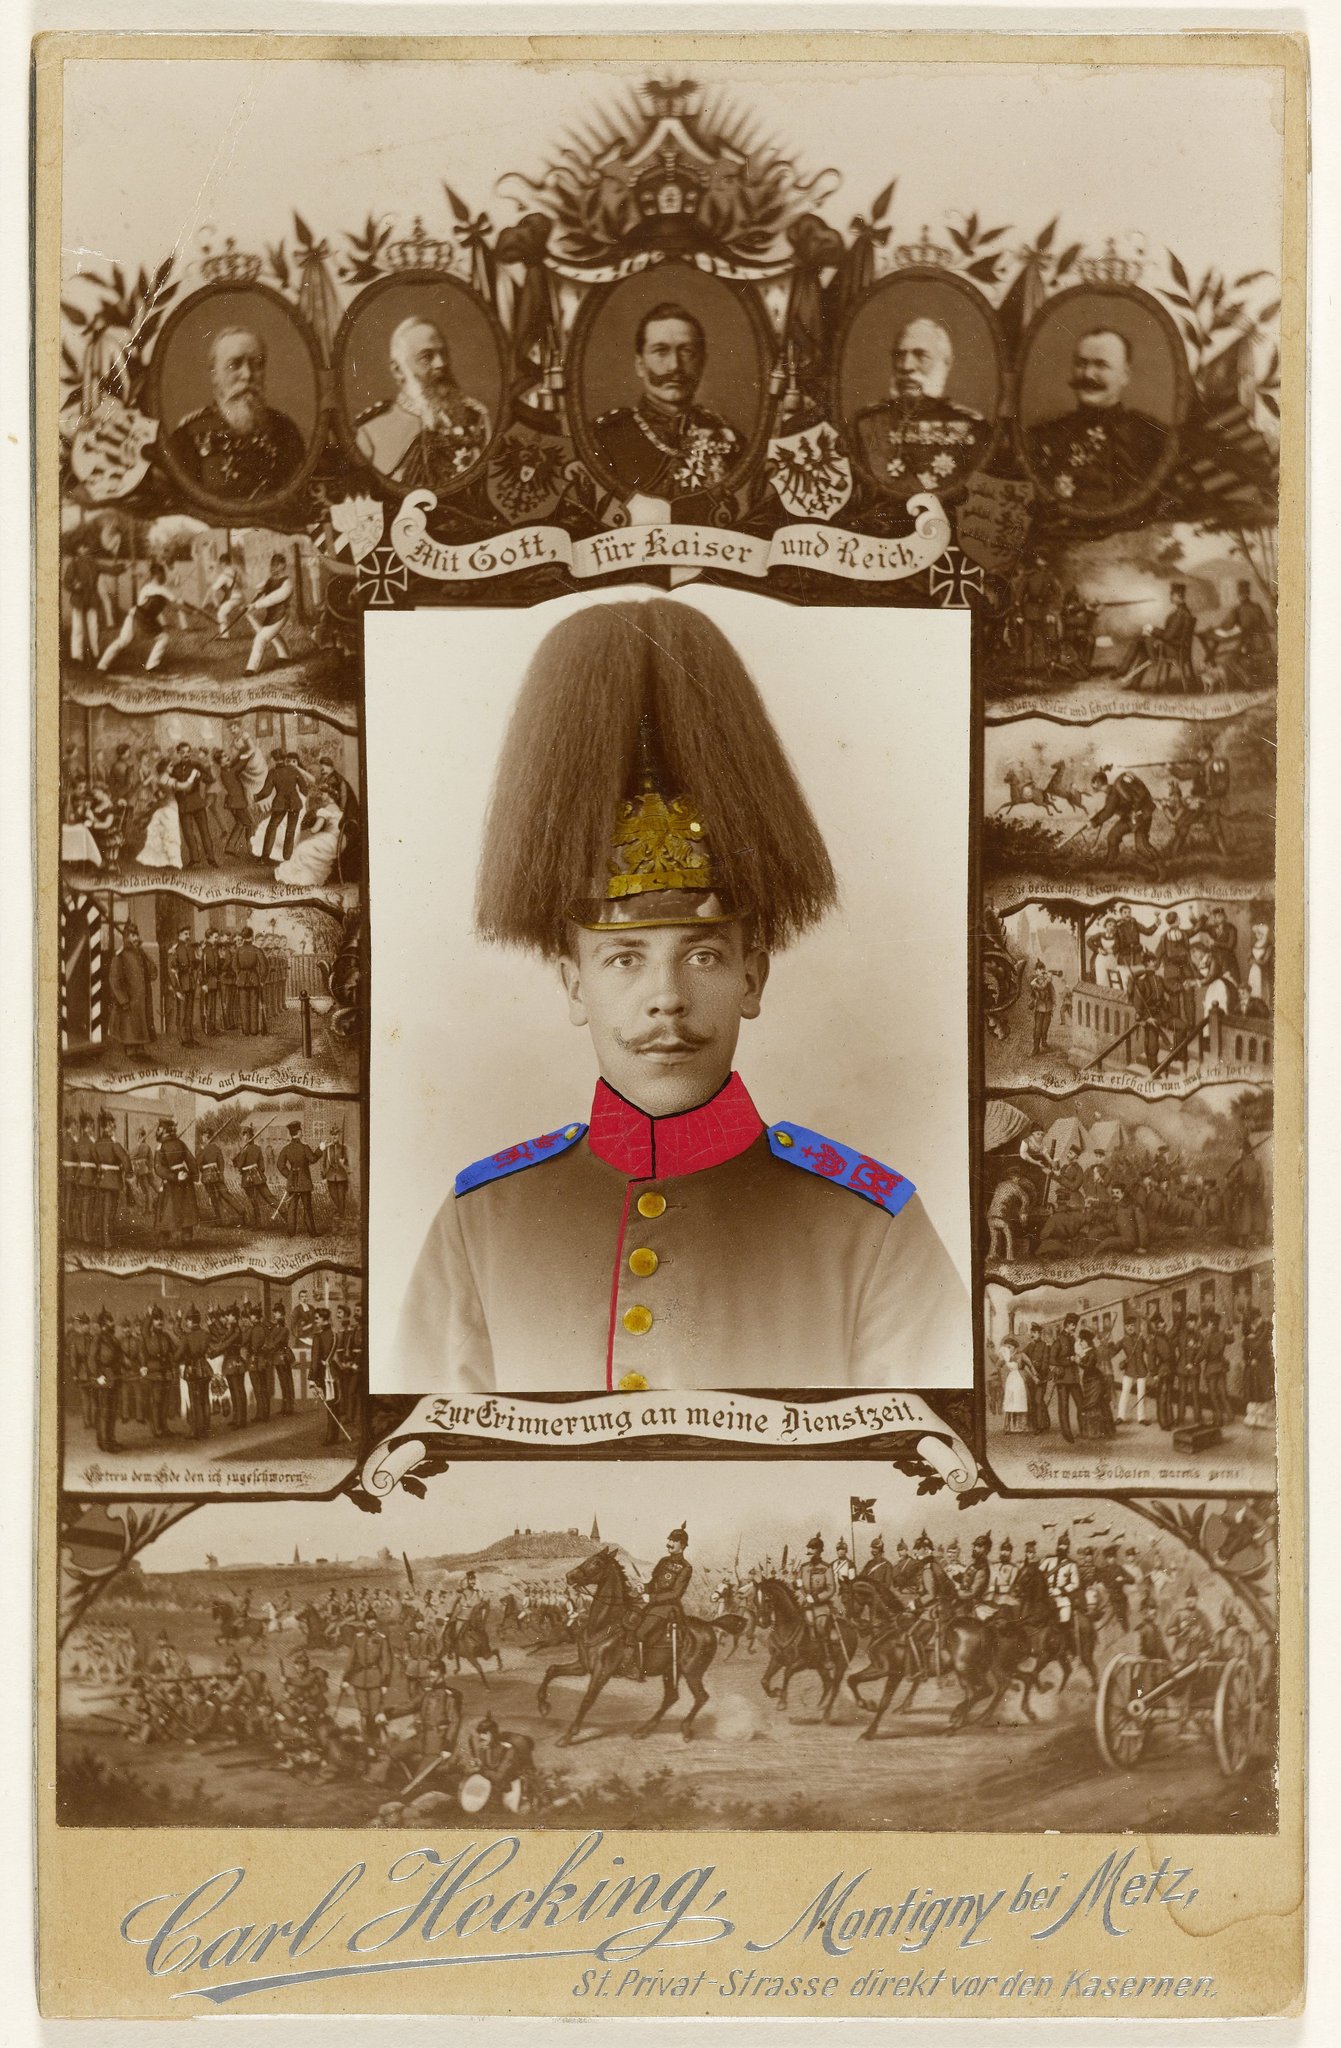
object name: cabinet photograph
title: Zur Erinnerung an meine Dienstzeit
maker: carl hecking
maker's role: fotograaf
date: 1890-1910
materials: cardboard, paper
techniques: hand coloring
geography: metz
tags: wilhelm ii (keizer van duitsland), anonymous historical person portrayed, the soldier; the soldier's life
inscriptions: annotation: ‘CH // Carl Hecking // Photographisches // Atelier. // Montignÿ [sic] b/Metz. // St. Privat-Strasse //direct vor der Kaserne // Bitte genau auf Firma // achten zu wollen // Die Platte // bleibt für // Nachbestellungen // aufbewahrt. // Vergrösserungen nach jedem Bilde // bis Lebensgrösse. // Rommel & Co., Nerchau.’, annotation: ‘Carl Hecking // Montigny bei Metz, // St. Privat-Strasse direct vor den Kasernen.’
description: Met randvoorstellingen van scènes uit het militaire leven en vijf portretten, waaronder dat van keizer Wilhelm II.